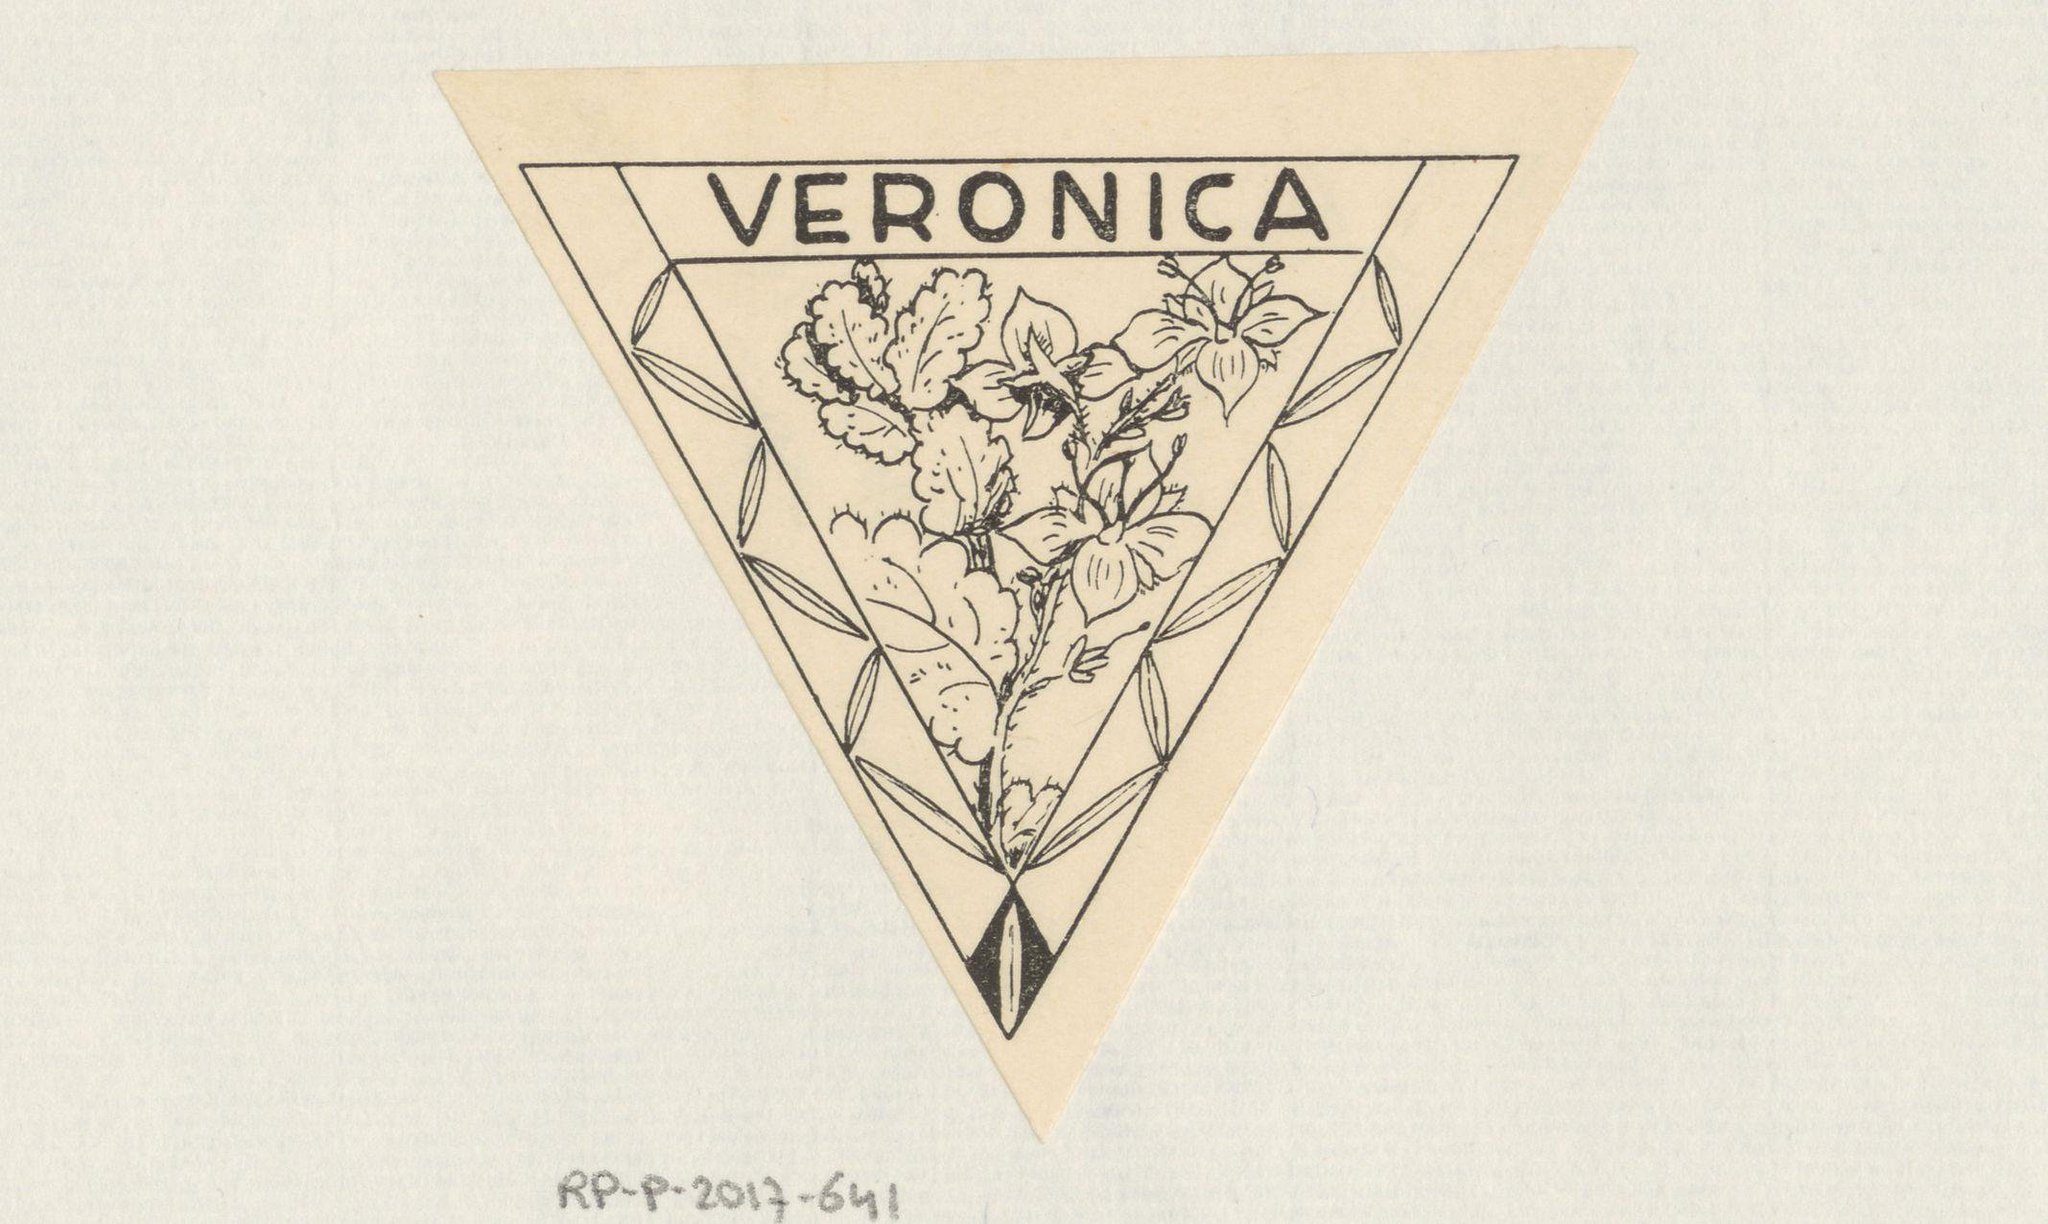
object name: bookplate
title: Ex libris van Veronica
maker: Anonymous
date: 1900-1999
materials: paper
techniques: printing block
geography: netherlands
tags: flowers